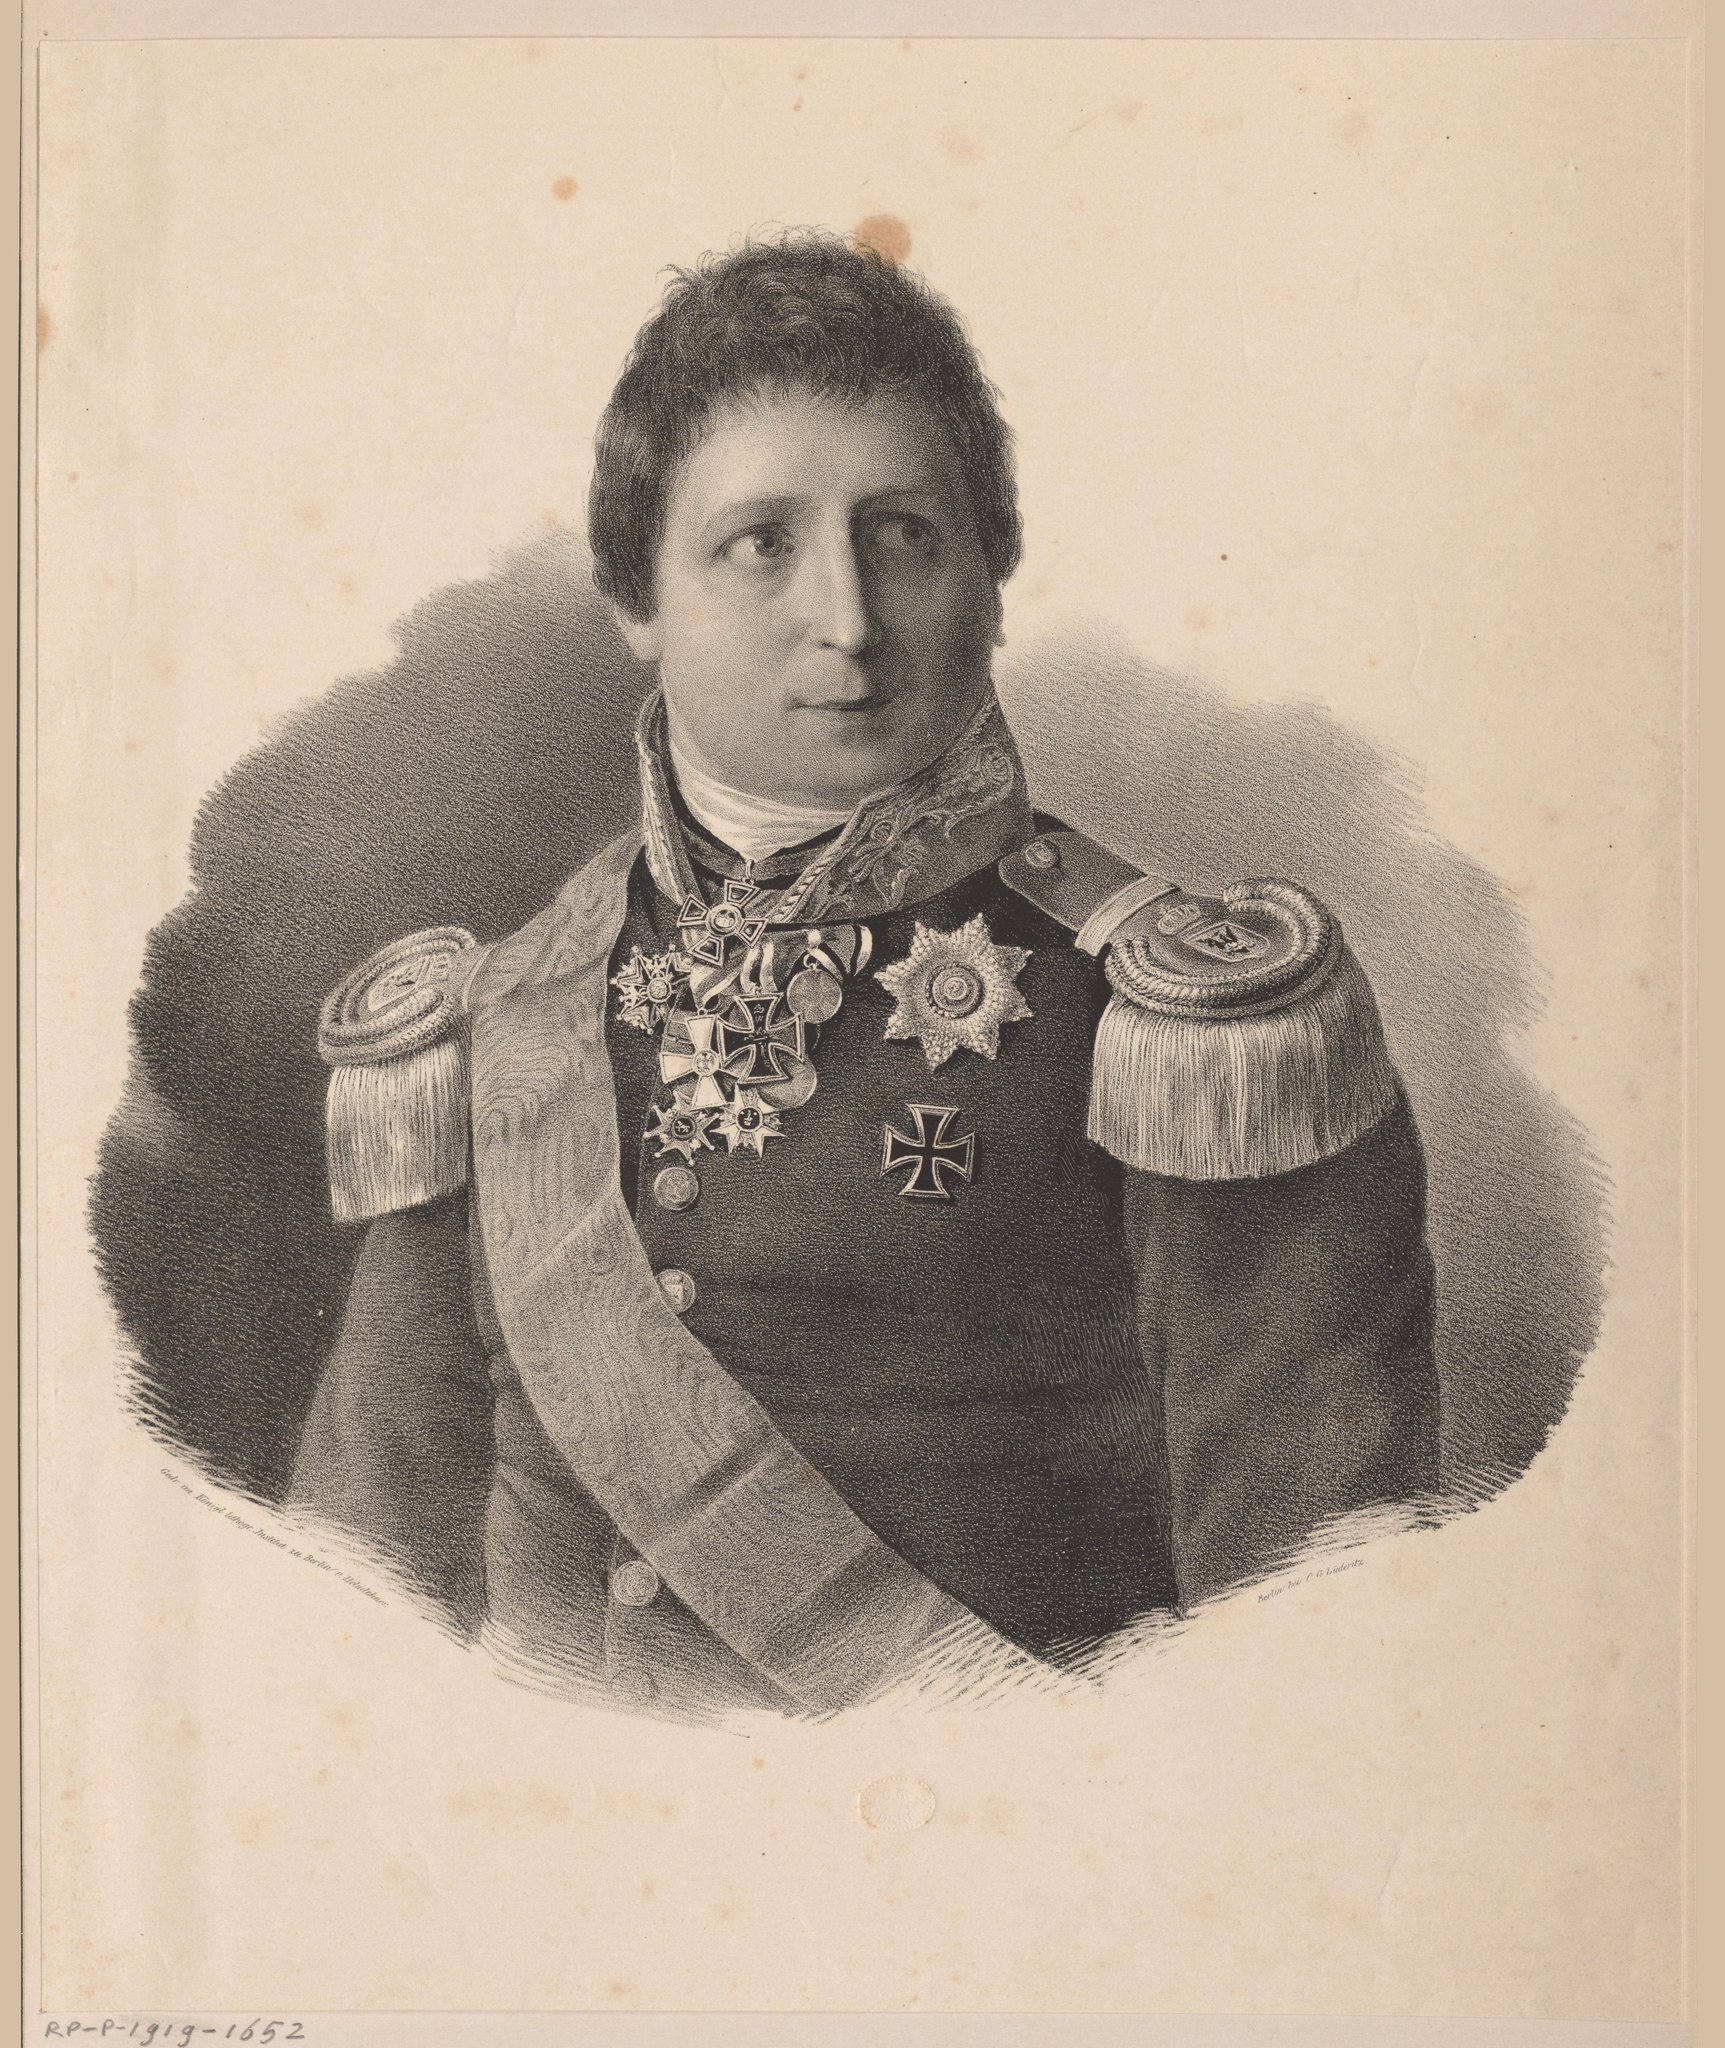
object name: print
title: Portret van Heinrich Schmückert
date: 1818-1837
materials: paper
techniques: lithograph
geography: berlin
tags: commander-in-chief, general, marshal, historical persons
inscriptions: check stamp: Lugt 4519, collector's mark: Lugt 2228